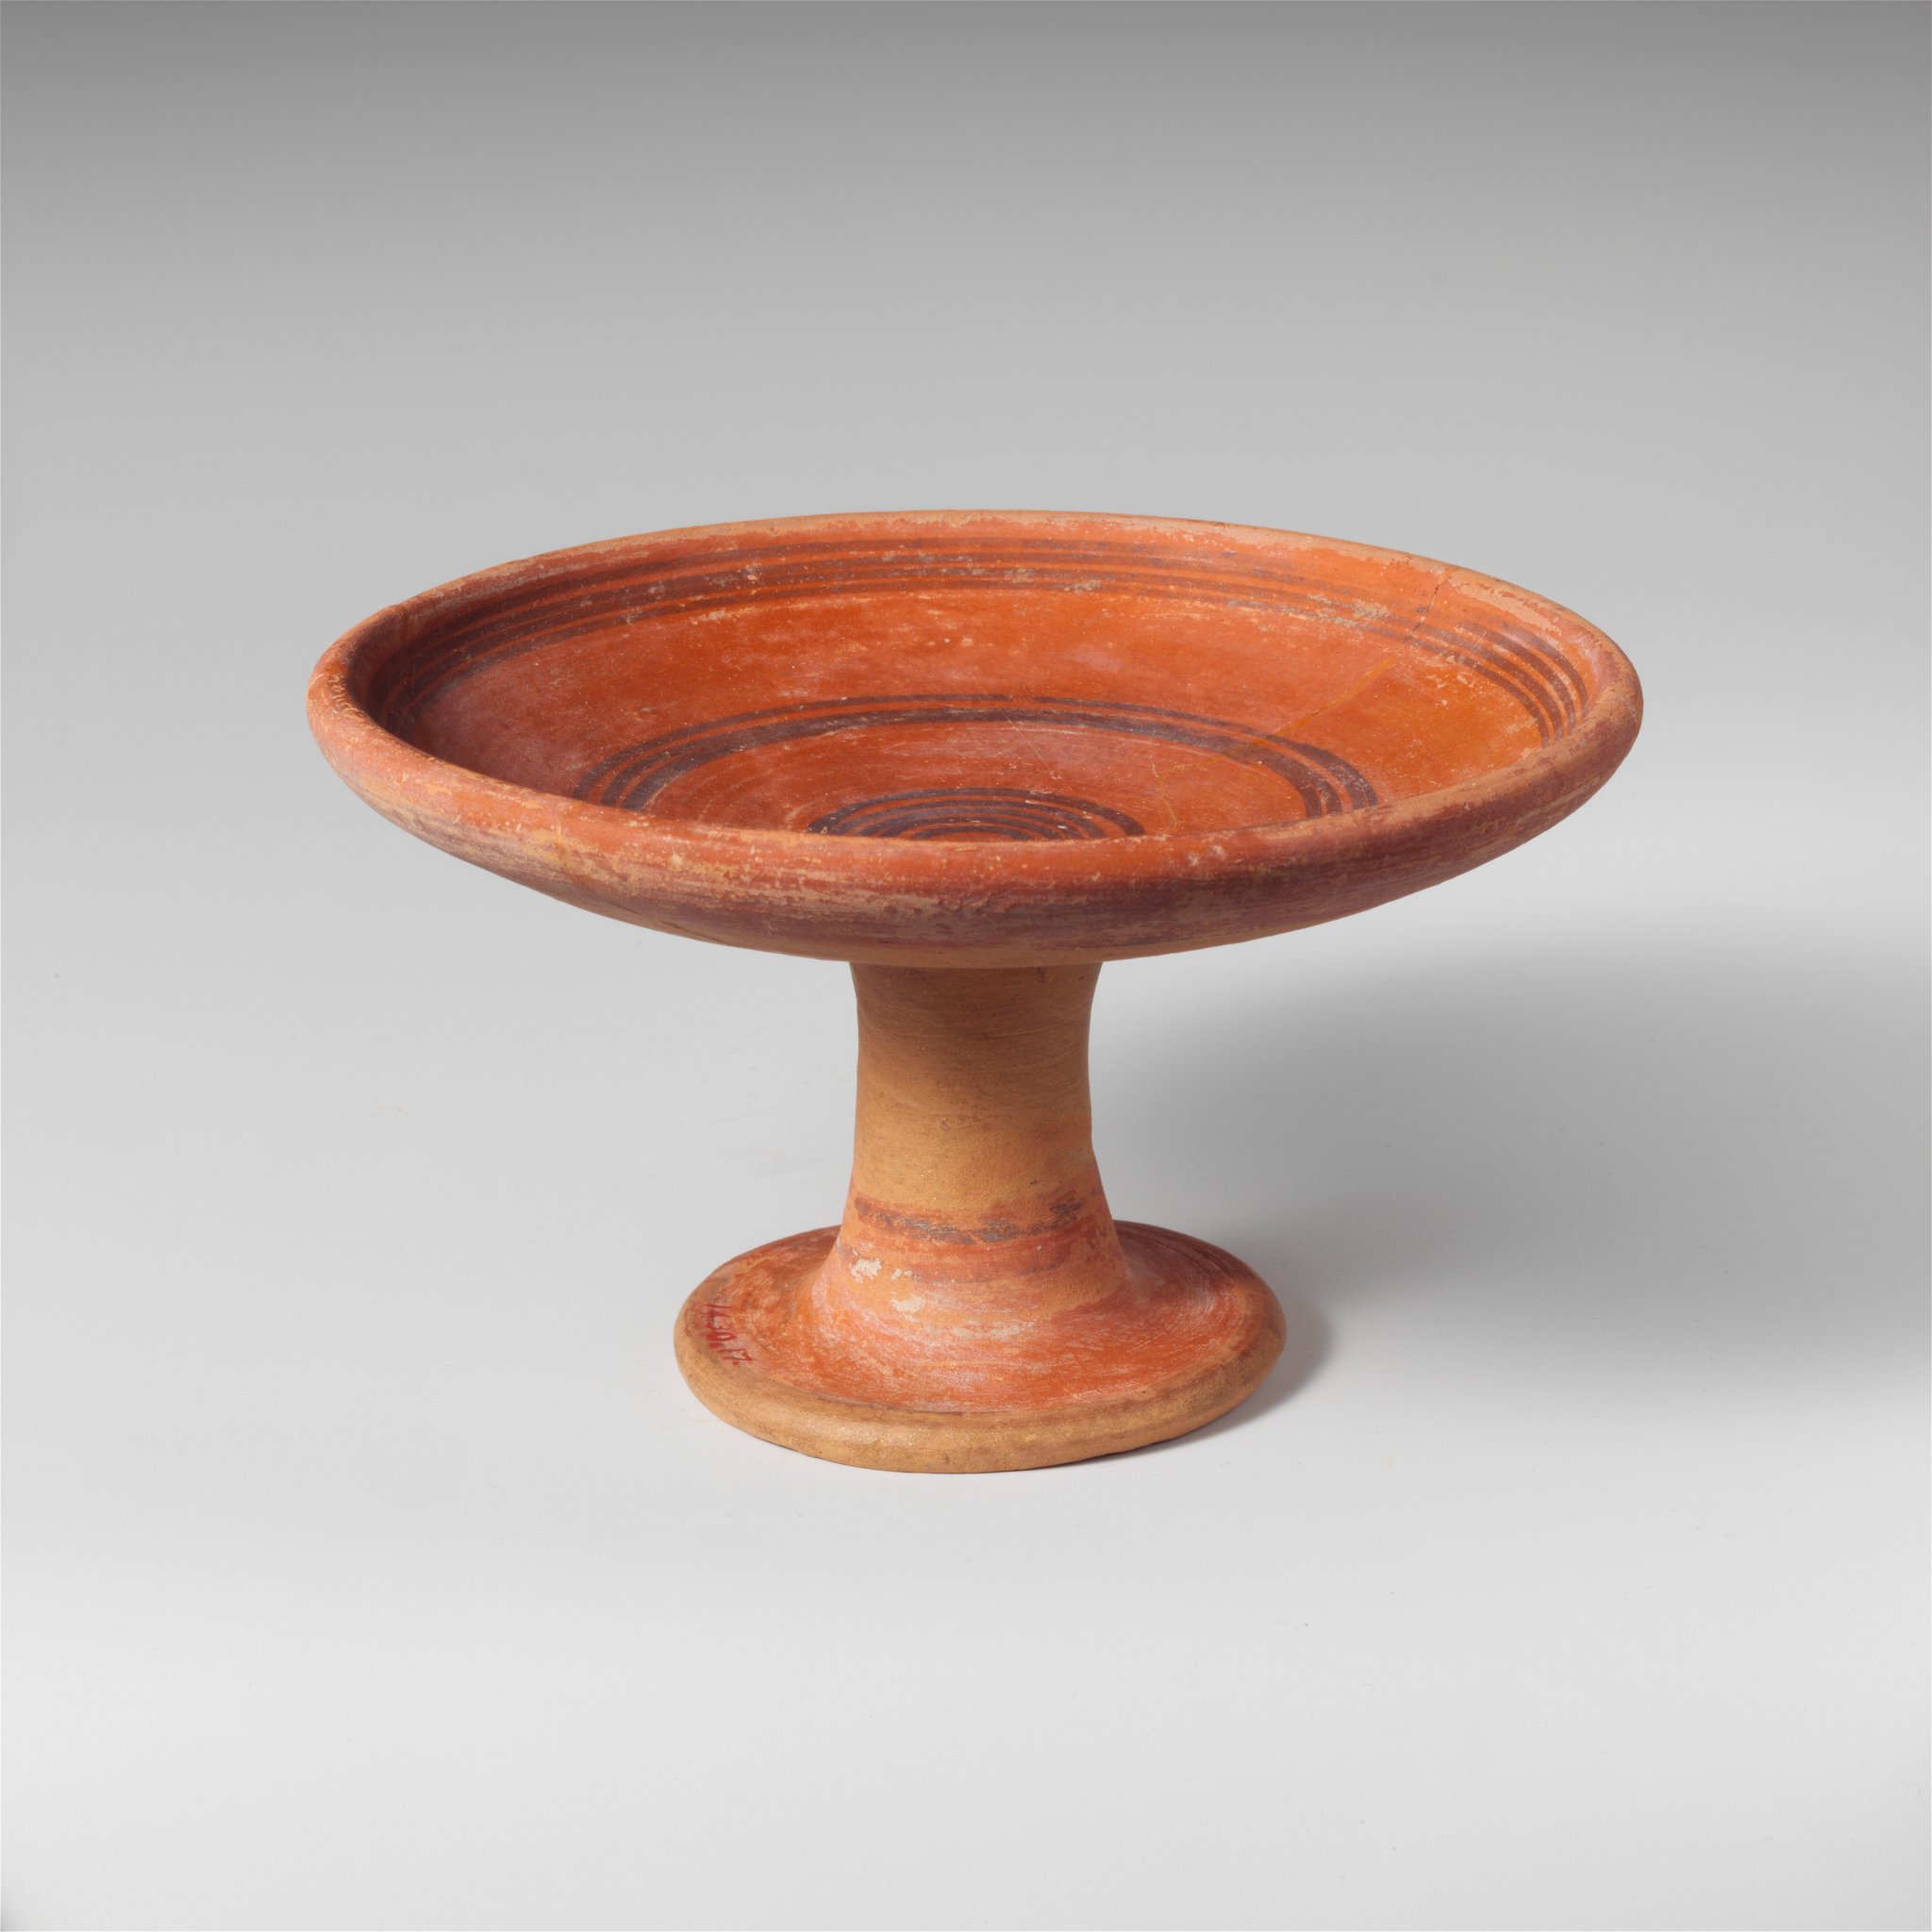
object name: stemmed dish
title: Terracotta stemmed dish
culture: lydian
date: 600-501 BCE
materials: terracotta